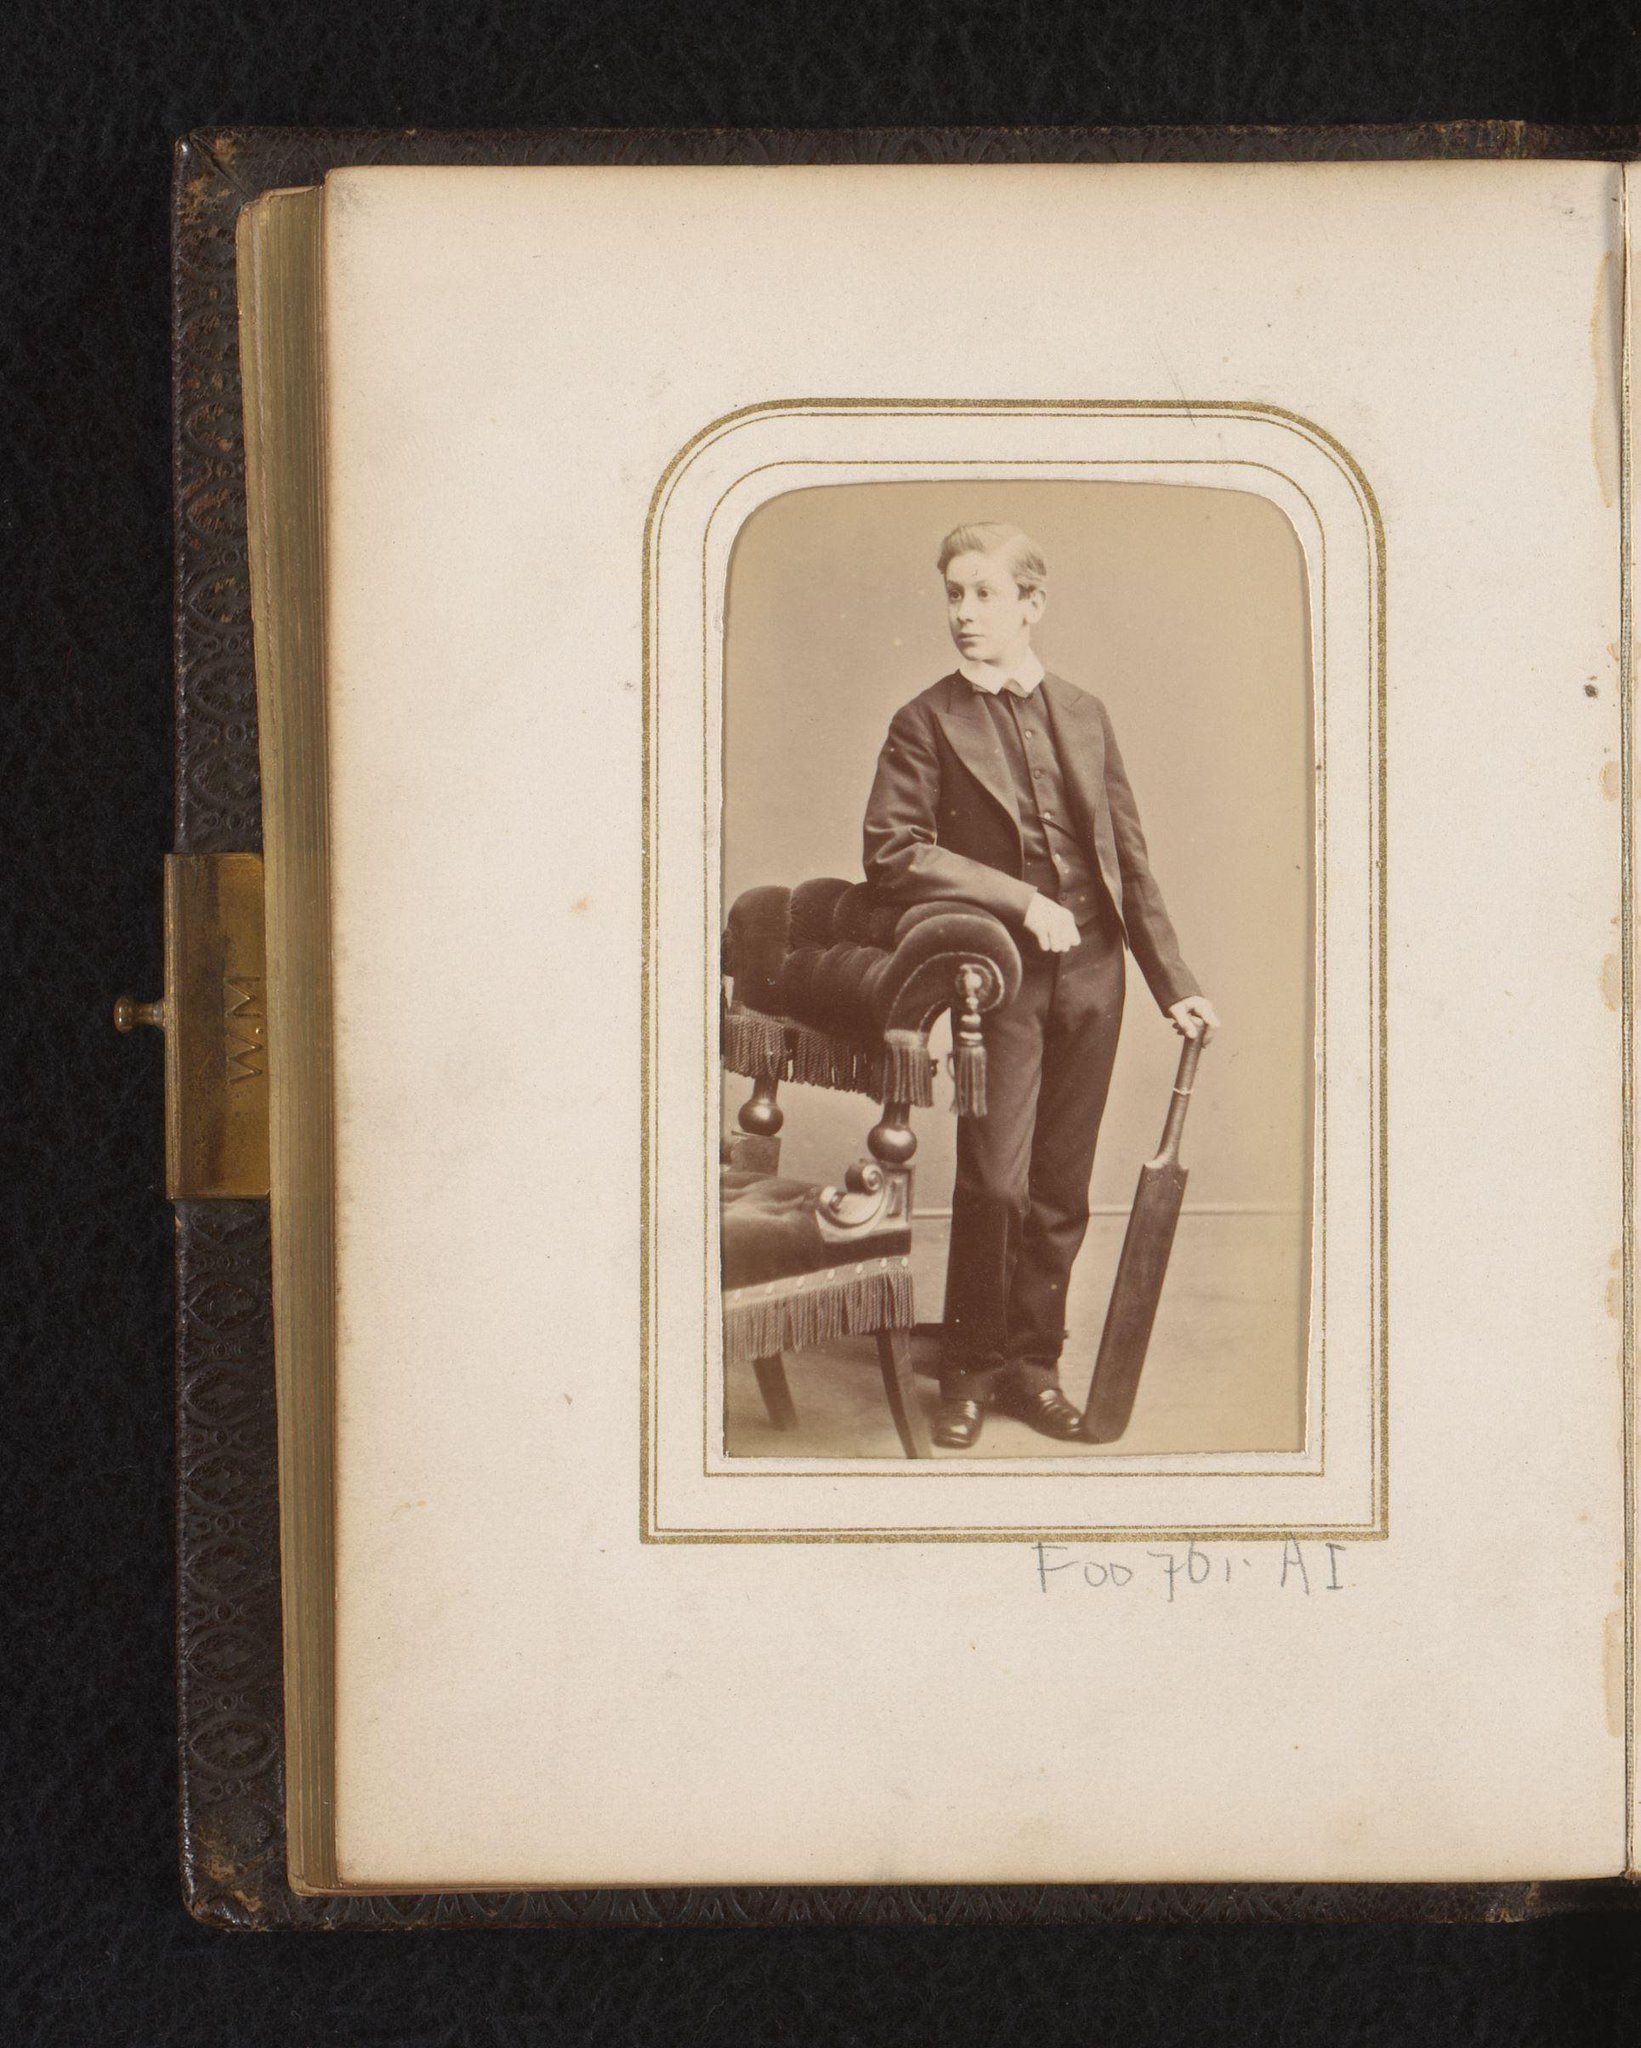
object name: album leaf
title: Portret van een jongen met cricketslaghout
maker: silas eastham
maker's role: fotograaf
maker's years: 1824-1901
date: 1860-1880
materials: cardboard, photographic support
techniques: albumen print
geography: southport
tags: cricket (ball game), boy (child between toddler and youth)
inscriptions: inscription: ‘Silas Eastham/ Photographer/ 217, Lord Street/ Southport’